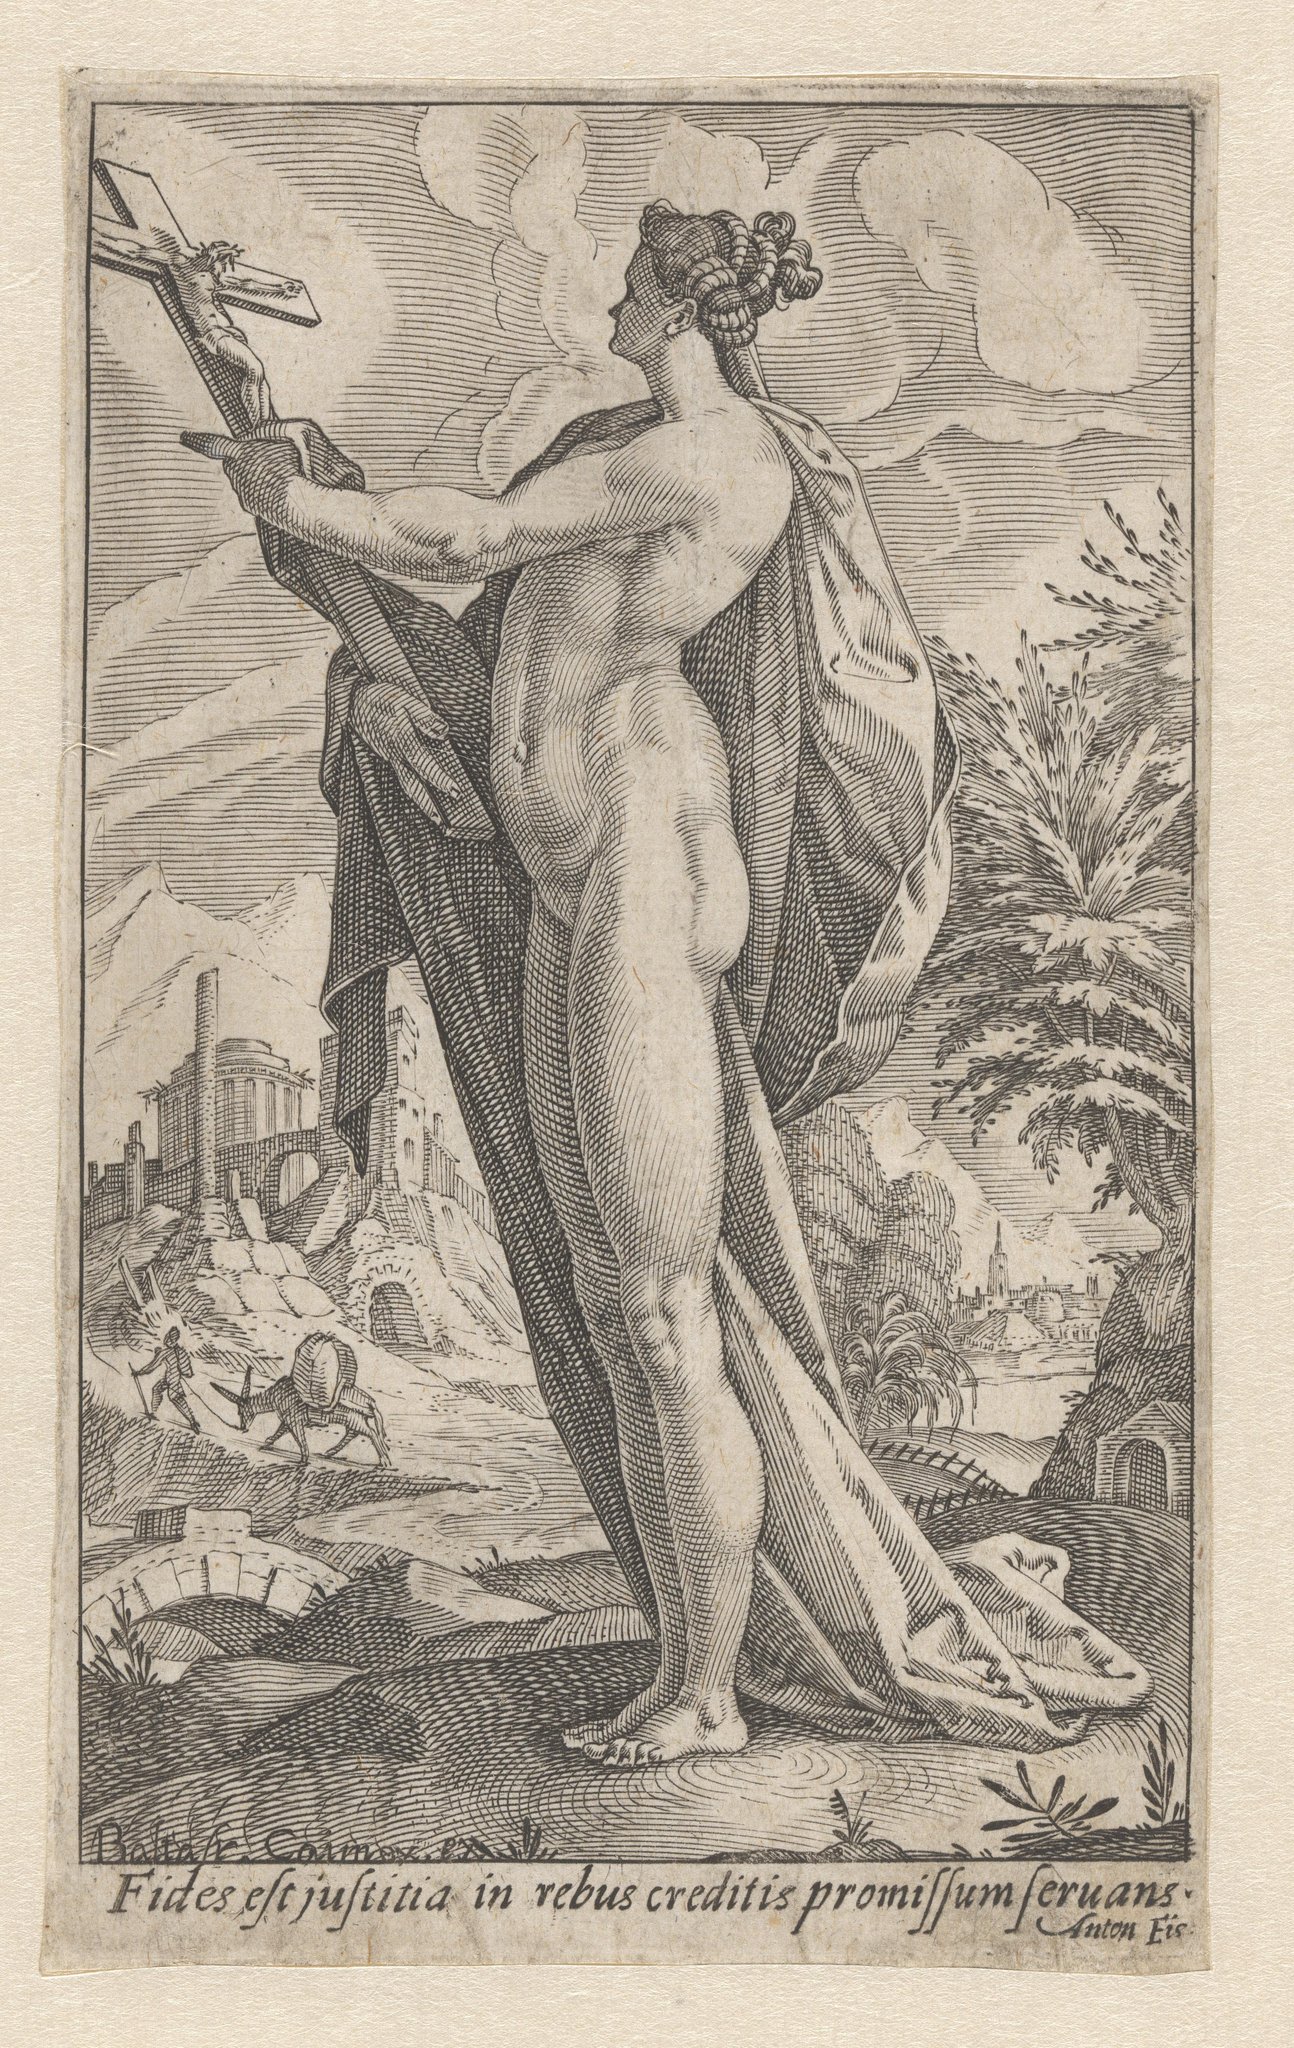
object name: print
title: Fides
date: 1591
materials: ink, paper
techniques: engraving, etching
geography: germany